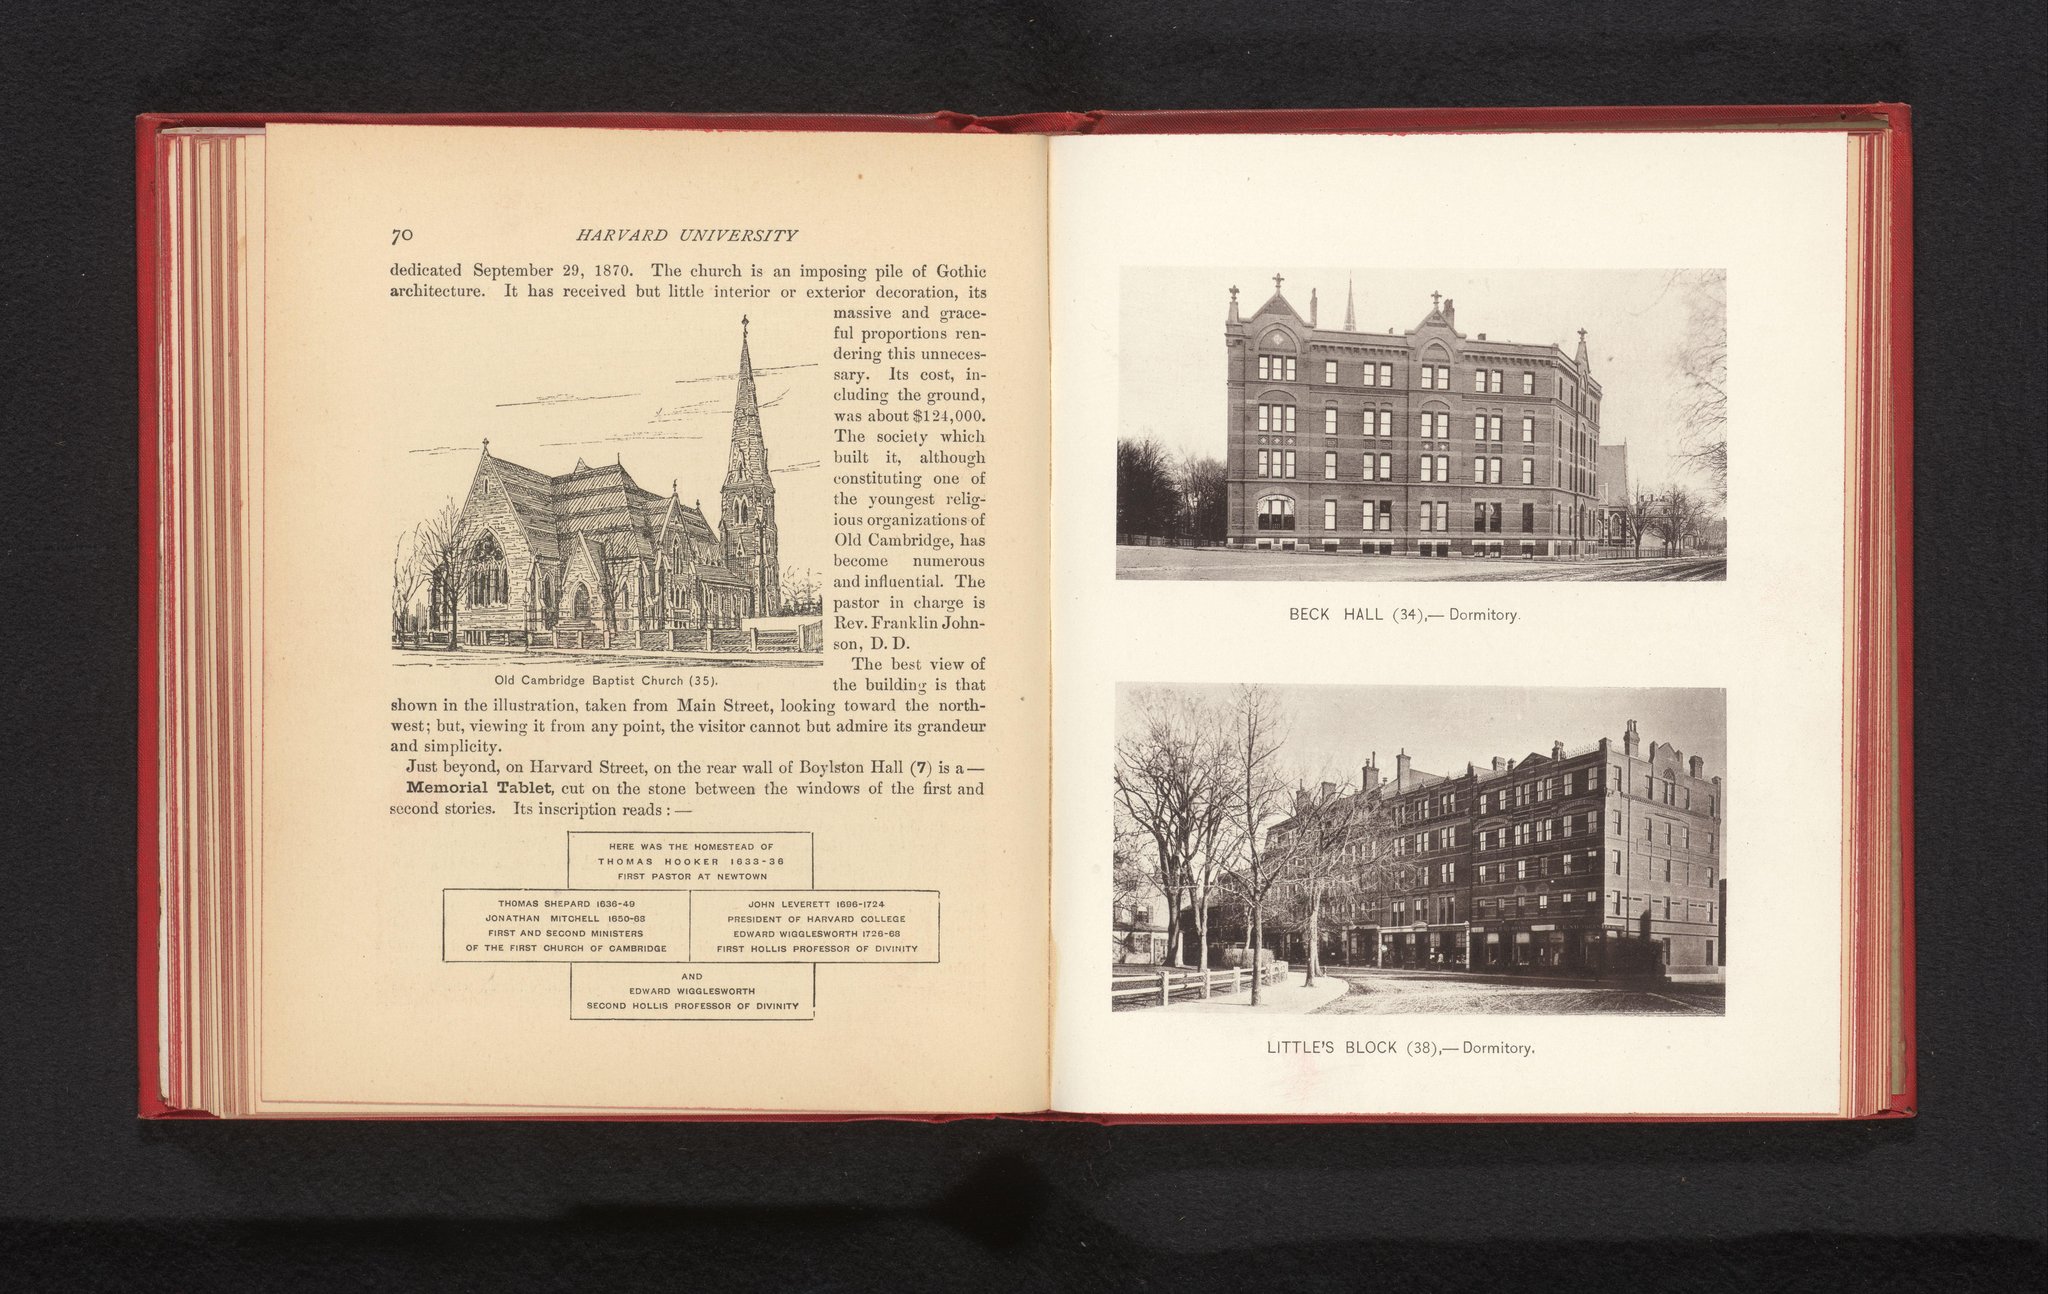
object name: page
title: Beck Hall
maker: Anonymous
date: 1881-1886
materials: paper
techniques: photograph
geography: cambridge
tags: university building, college, façade (of house or building)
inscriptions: number: ‘(34) (38)’